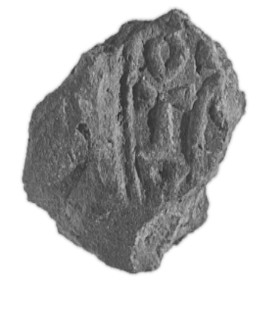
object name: sealing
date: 2030-1640 BCE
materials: clay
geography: egypt